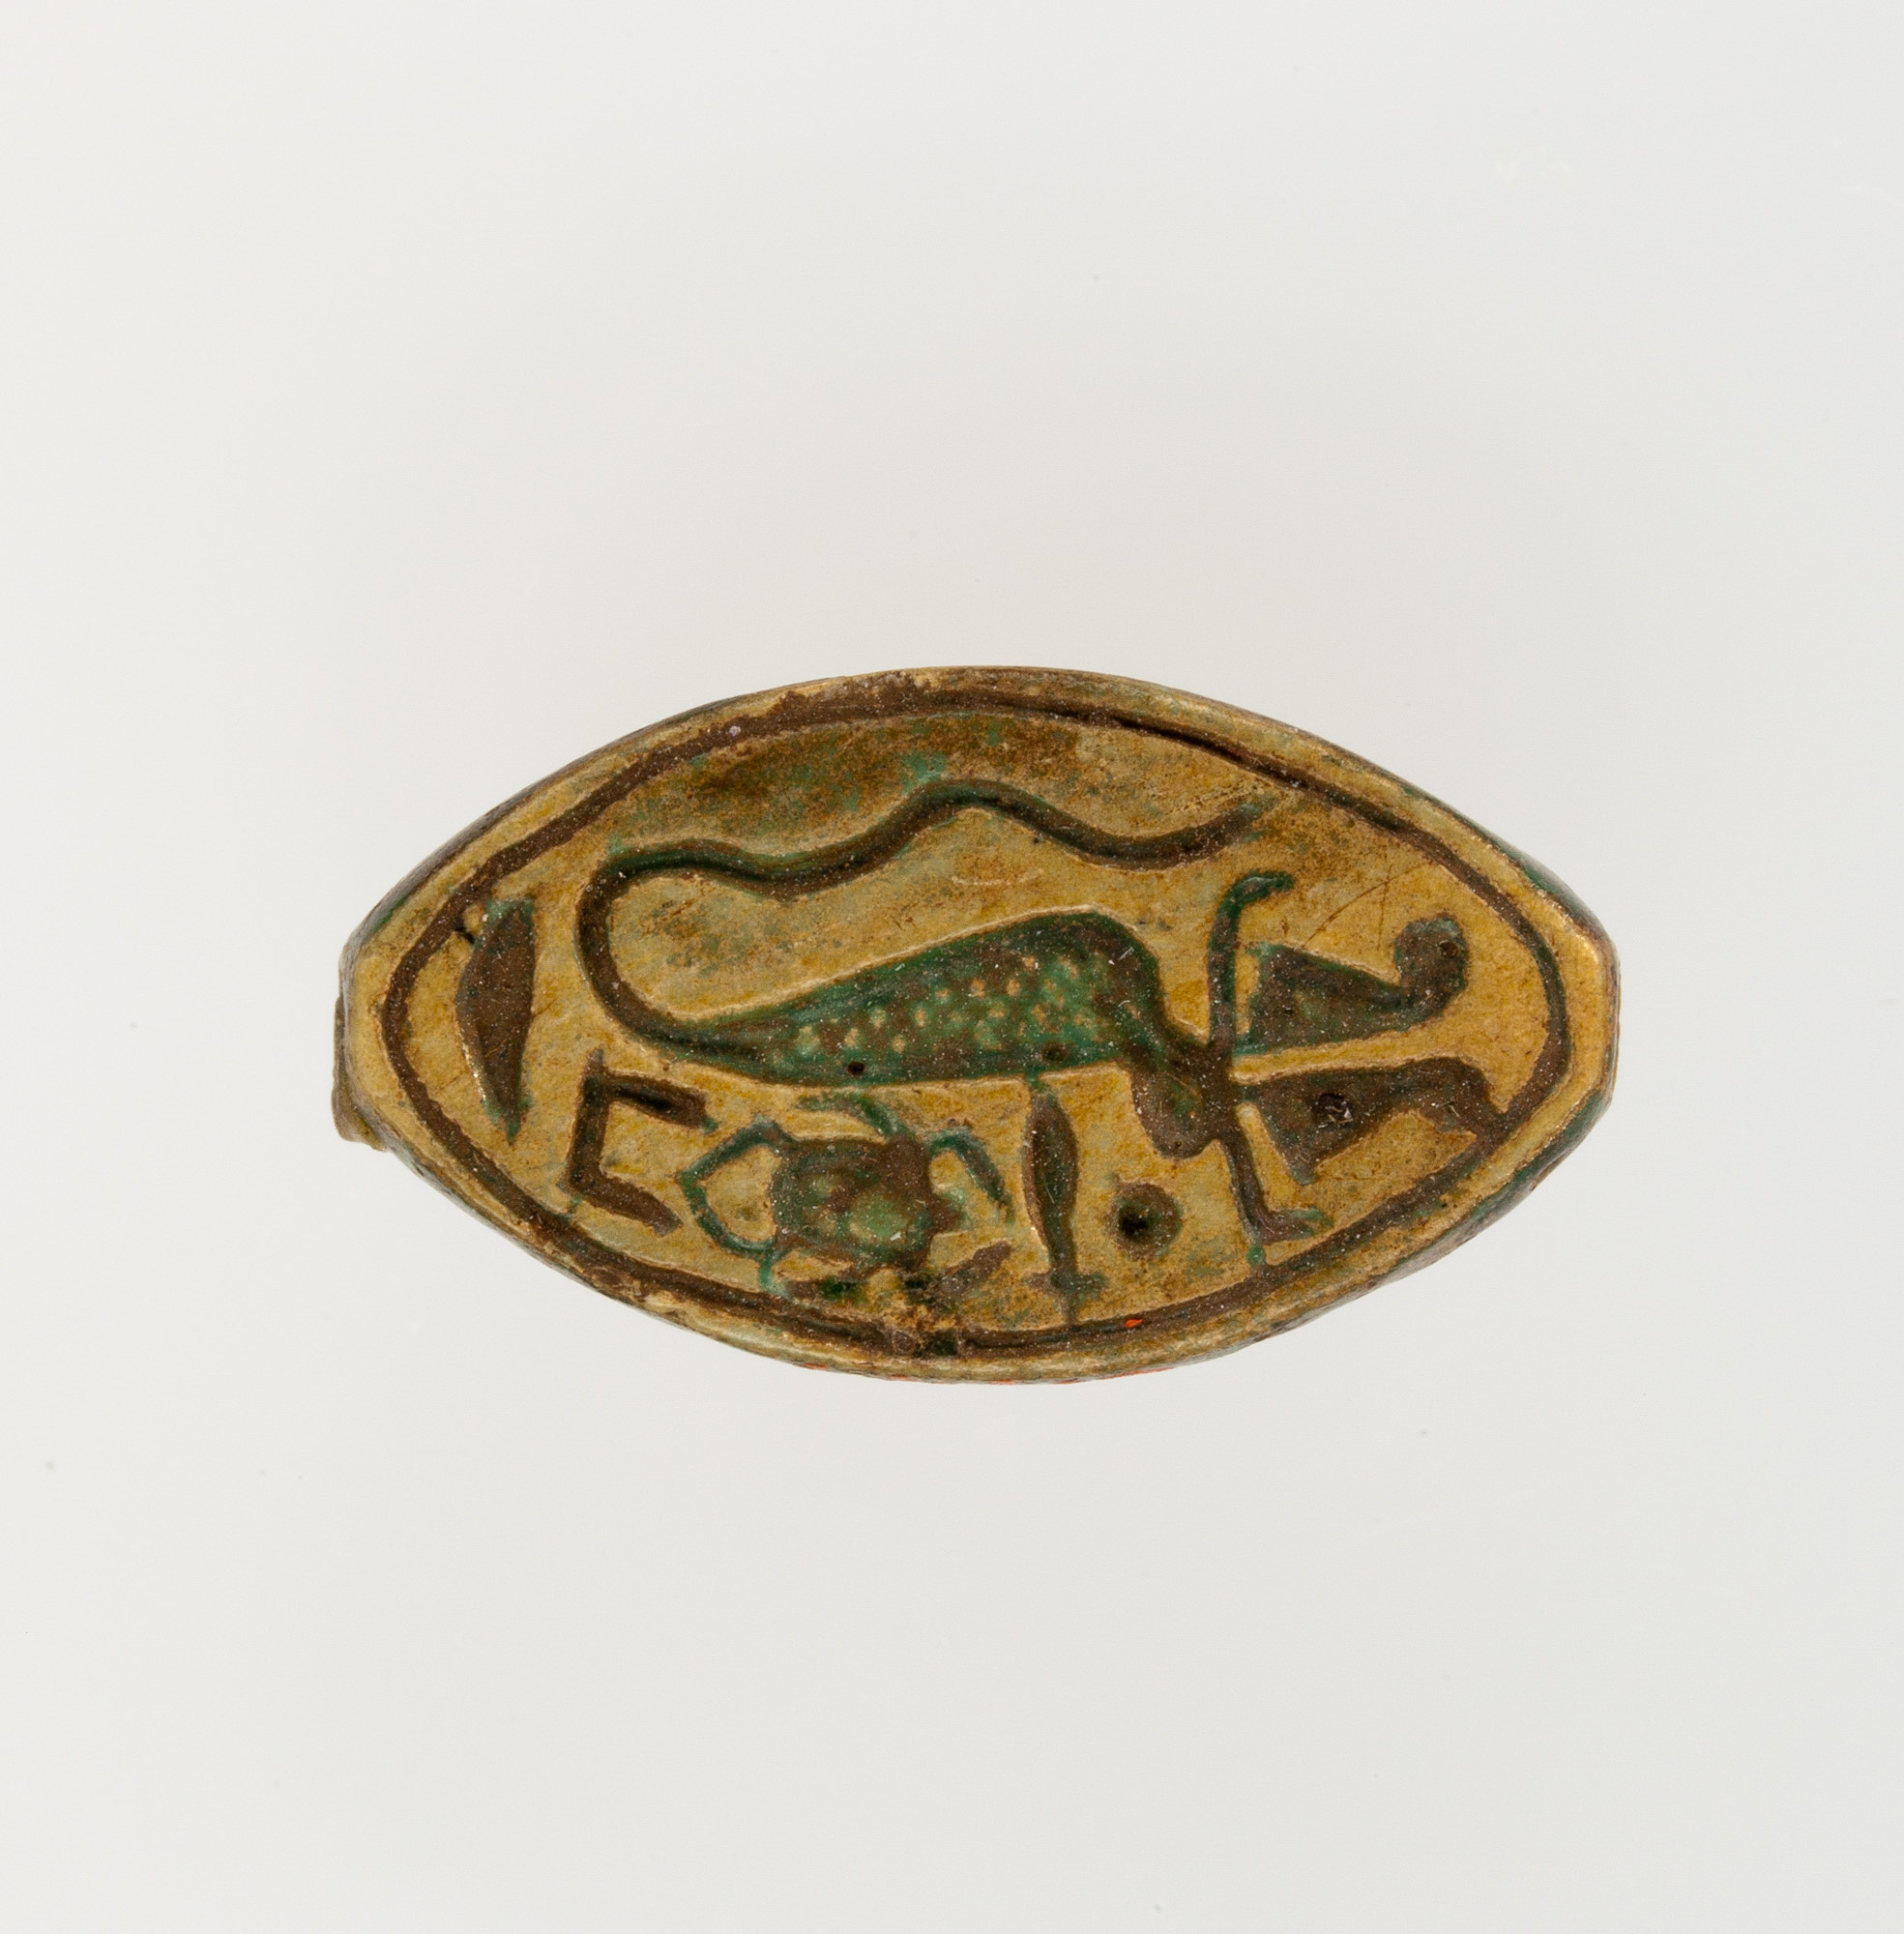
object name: cowroid, thutmose i, aakheperkare,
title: Stamp Seal Inscribed with the Throne Name of Thutmose I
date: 1504-1492 BCE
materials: faience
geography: egypt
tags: hieroglyphs